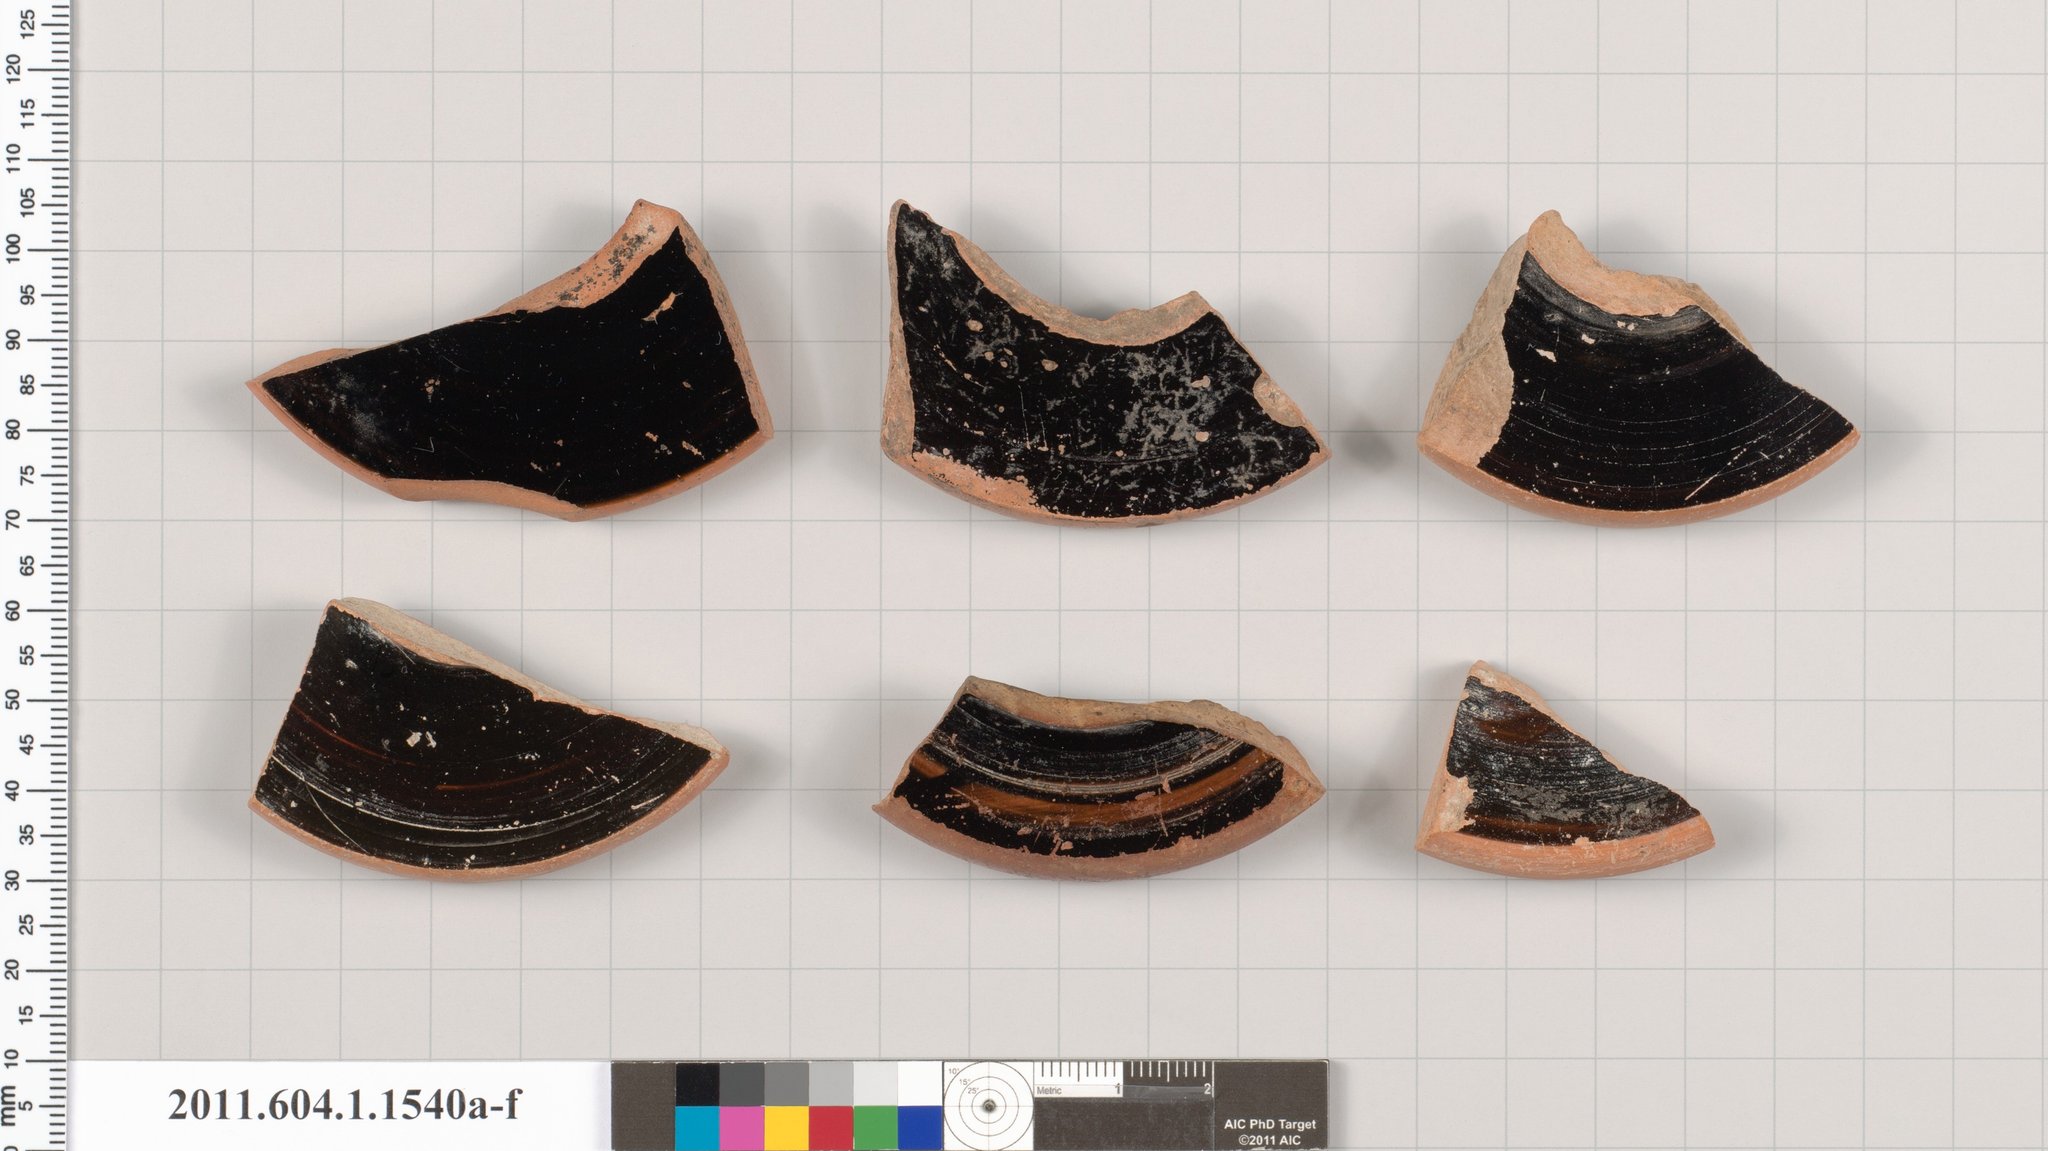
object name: kylix fragment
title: Terracotta fragments of kylikes (drinking cups)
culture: greek, attic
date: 500-401 BCE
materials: terracotta